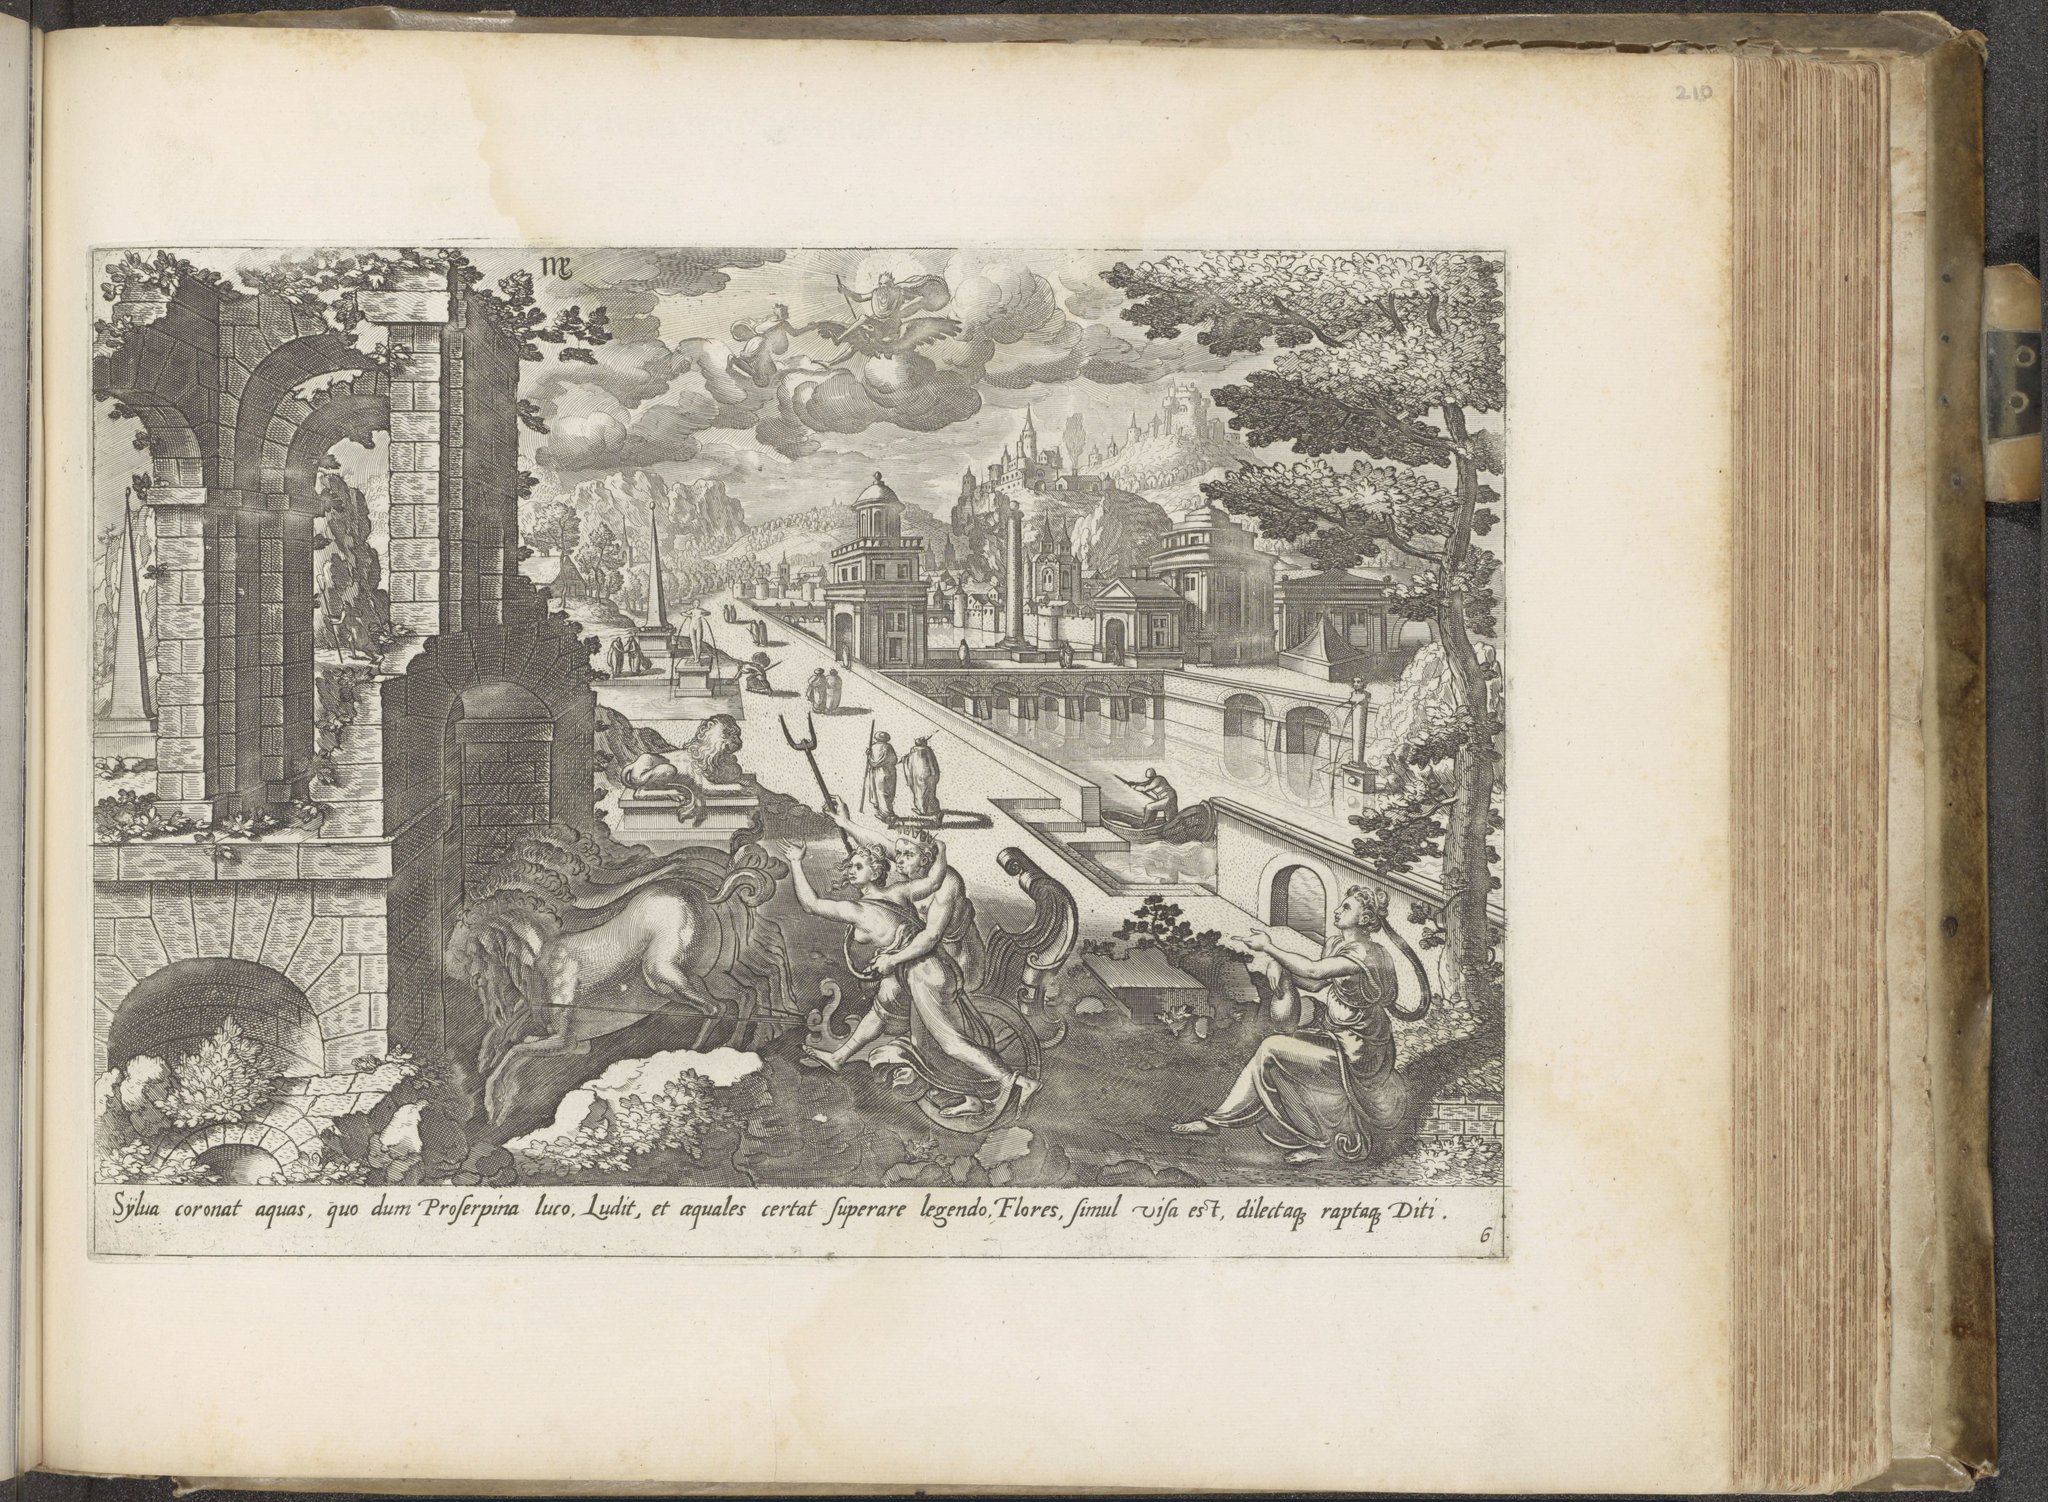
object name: print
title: Den Grooten Emblemata Sacra, bestaande in meer dan vier hondert bybelsche figuren, zoo des Ouden als des Nieuwen Testaments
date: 1653-1654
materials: paper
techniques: etching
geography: antwerp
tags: city-view, and landscape with man-made constructions - ii - ideal landscapes, the rape of proserpina (by pluto in his chariot); possibly with diana and minerva trying to rescue her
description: Stadsgezicht met de roof van Proserpina. Uit de kloof op de voorgrond komt Pluto, de koning van de onderwereld, tevoorschijn. Hij trekt Proserpina op zijn wagen. In de wolken smeekt Ceres bij Jupiter om haar dochter. Onder de voorstelling een verklarende tekst uit de Metamorfosen van Ovidius, boek 5, versregel 388-395. Bovenaan het teken van de Maagd uit de dierenriem. De prent maakt deel uit van een album.